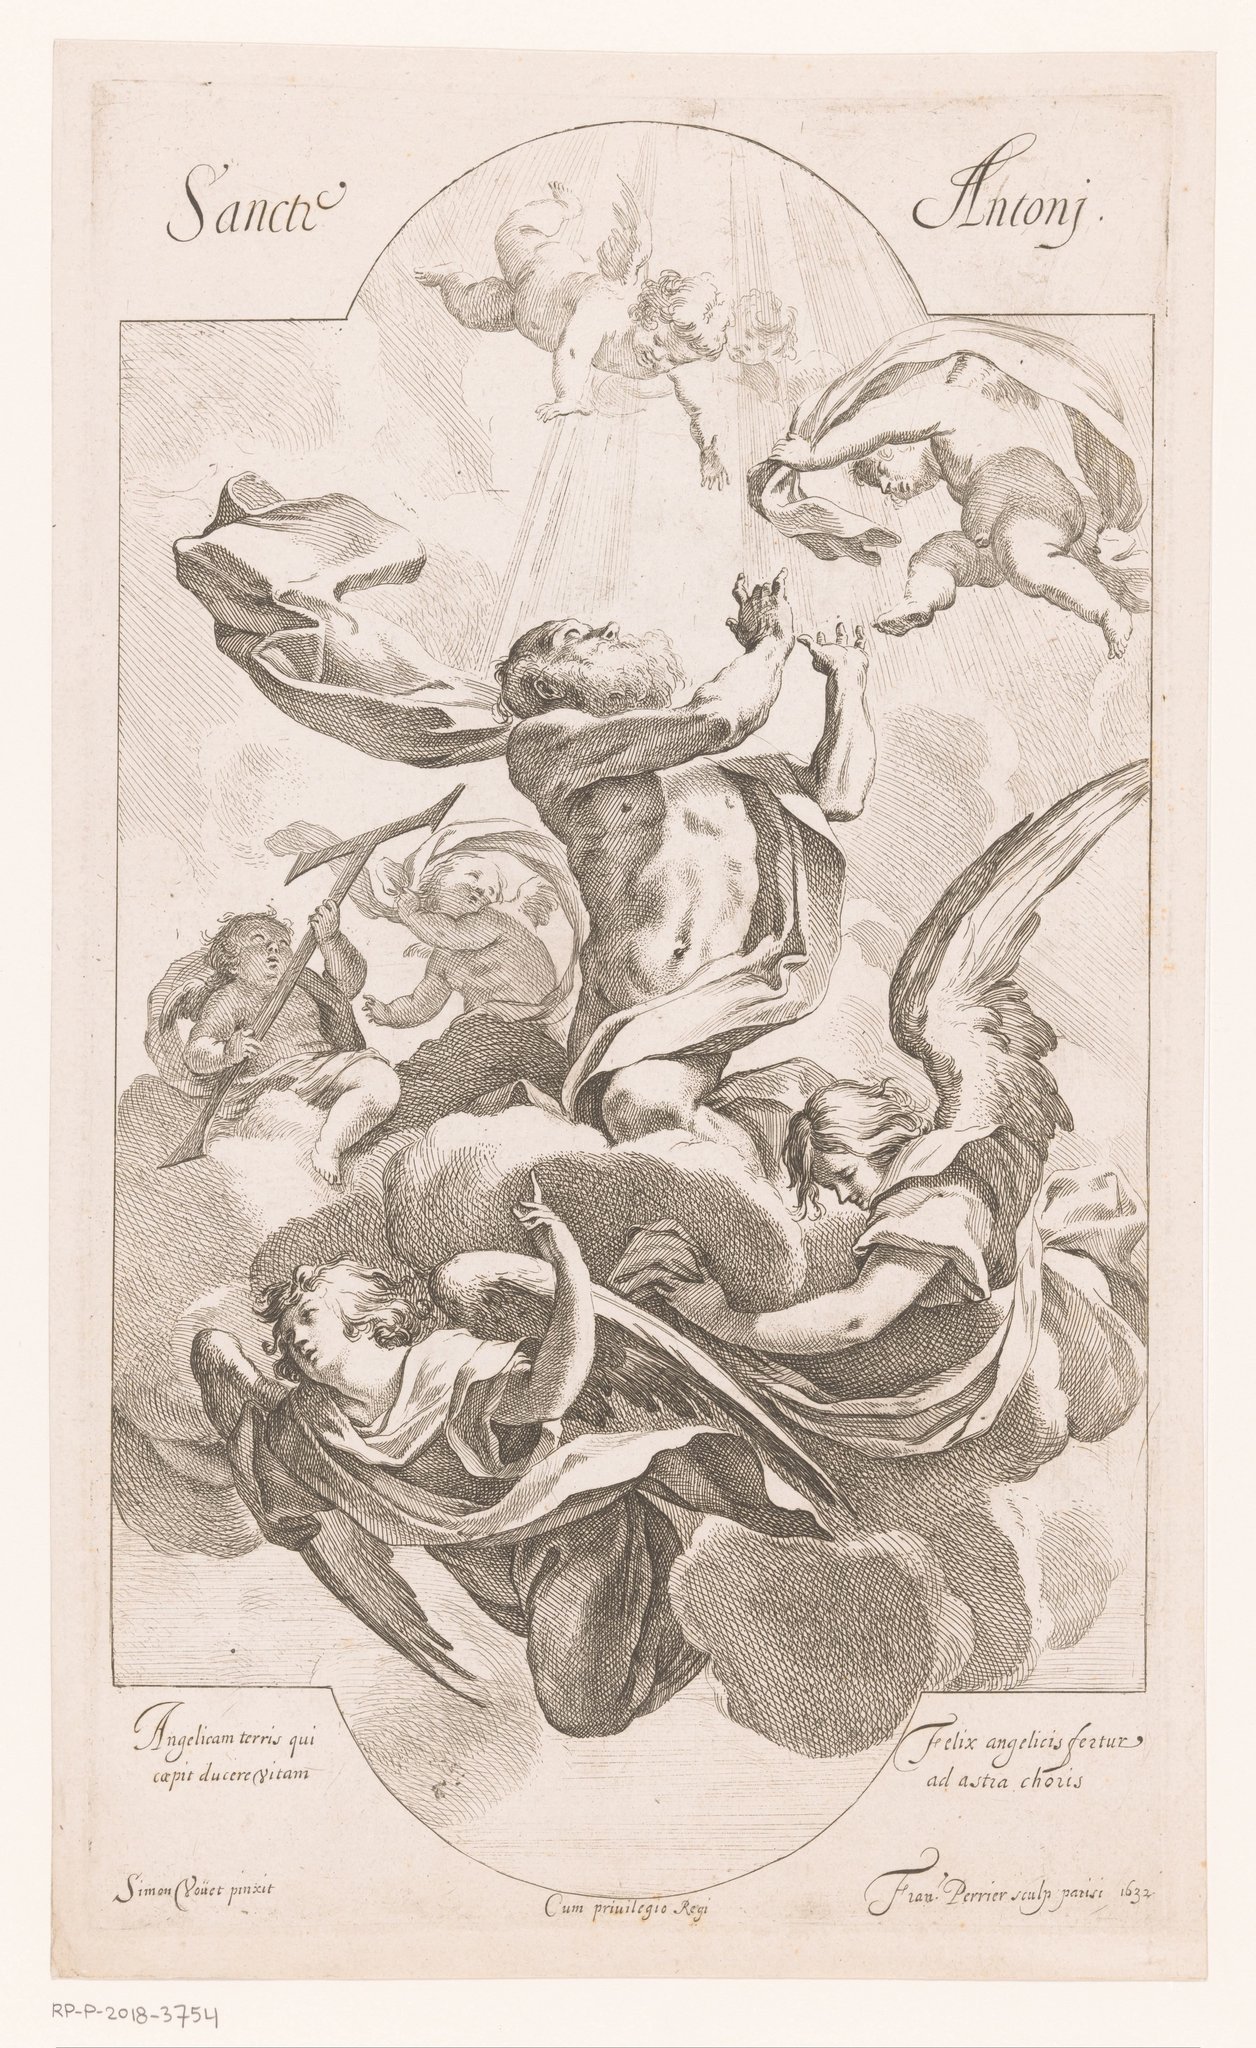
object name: print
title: Sancte Antoni/ Angelicam terris qui (...)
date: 1632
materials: paper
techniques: etching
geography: france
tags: the franciscan monk antony of padua; possible attributes: ass, book, crucifix, flowered cross, flaming heart, infant christ (on book), lily (+ angel(s))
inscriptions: date